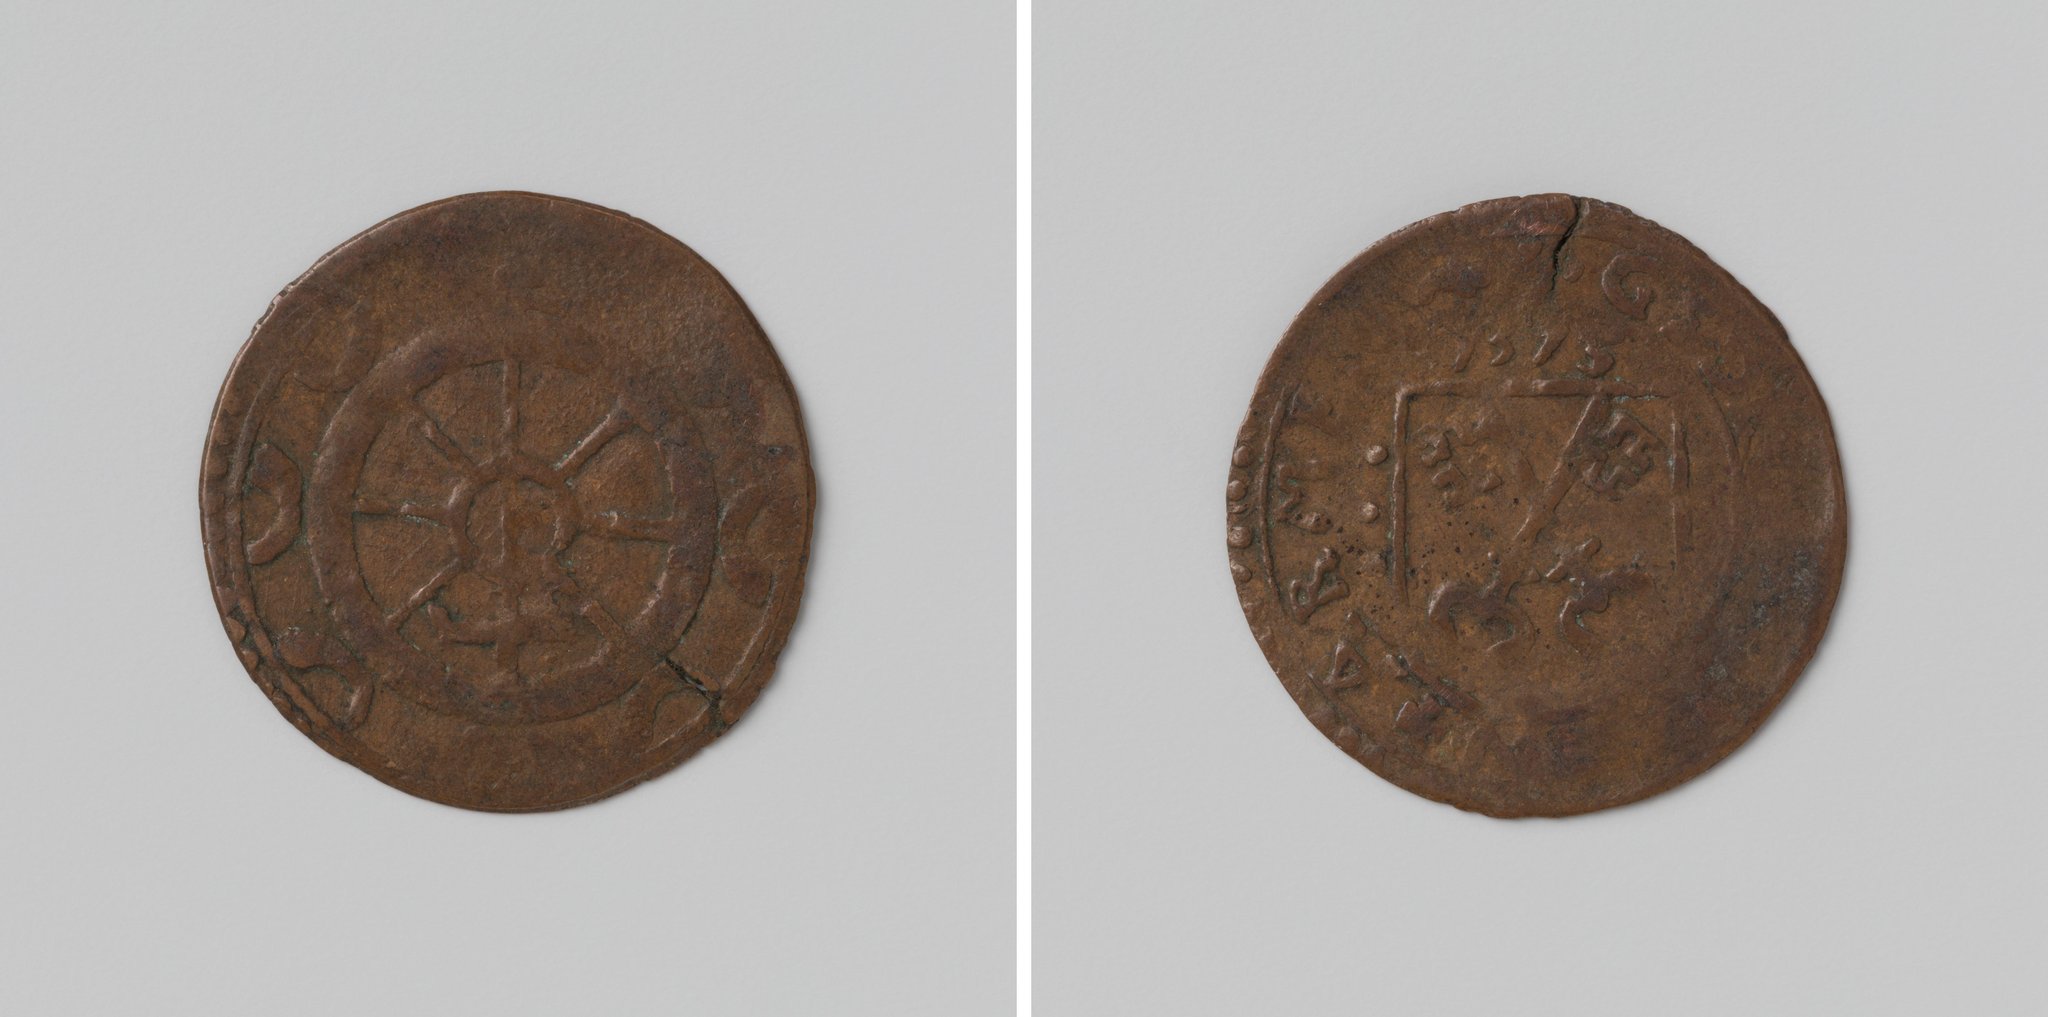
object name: alms token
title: Catharina-gasthuis van Leiden, armenpenning ter waarde van een oord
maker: Anonymous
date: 1573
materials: copper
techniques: striking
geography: leiden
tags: leiden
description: Koperen penning. Voorzijde: gekroond rad. Keerzijde: wapenschild onder jaartal binnen omschrift.